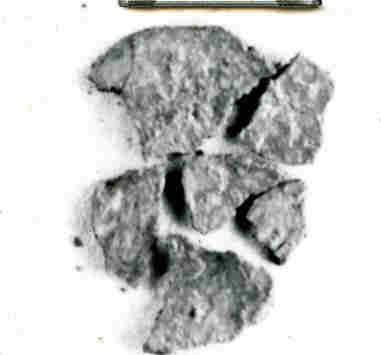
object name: coin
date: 401-1400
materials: copper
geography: iran